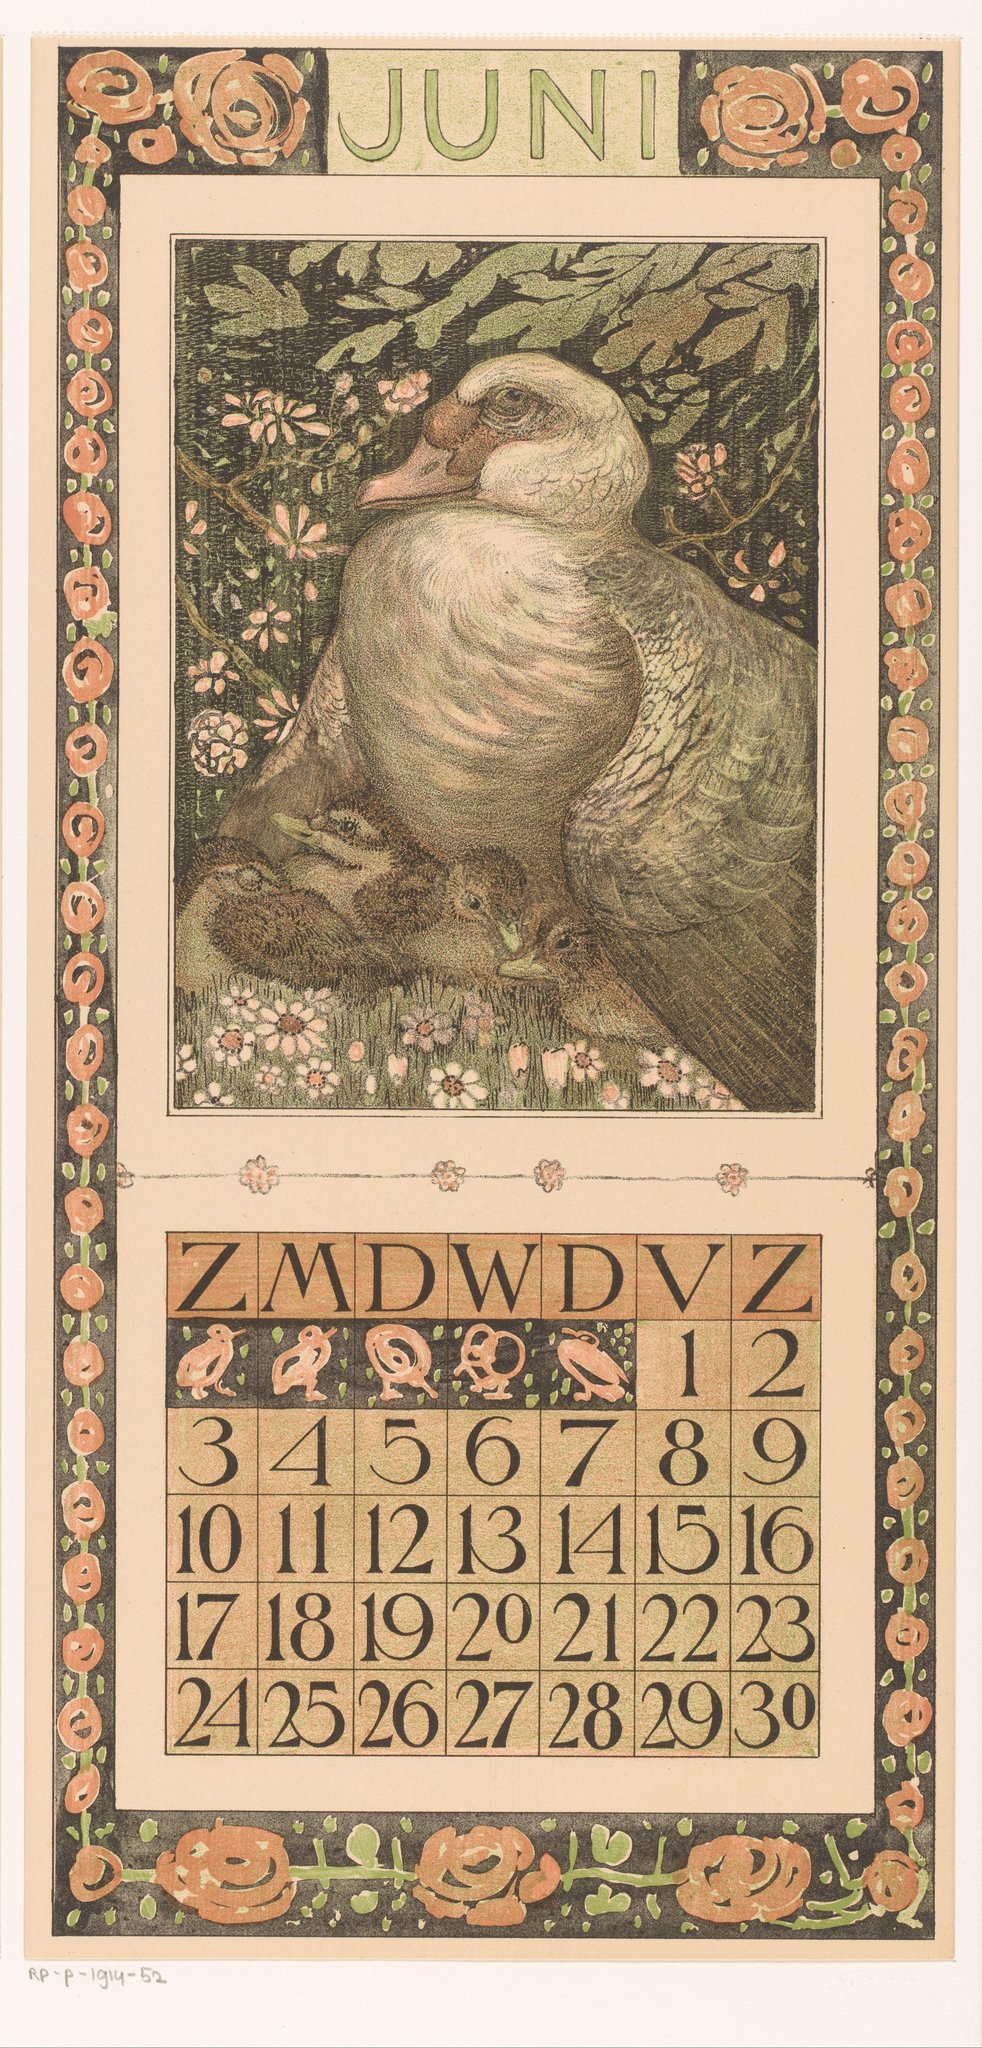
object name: print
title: Kalenderblad juni met eend met jongen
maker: theo van hoytema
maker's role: draughtsman, painter, print maker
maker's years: 1863-1917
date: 1905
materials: paper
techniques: lithograph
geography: amsterdam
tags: water-birds: duck, june ~ other concepts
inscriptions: collector's mark: Lugt 2228